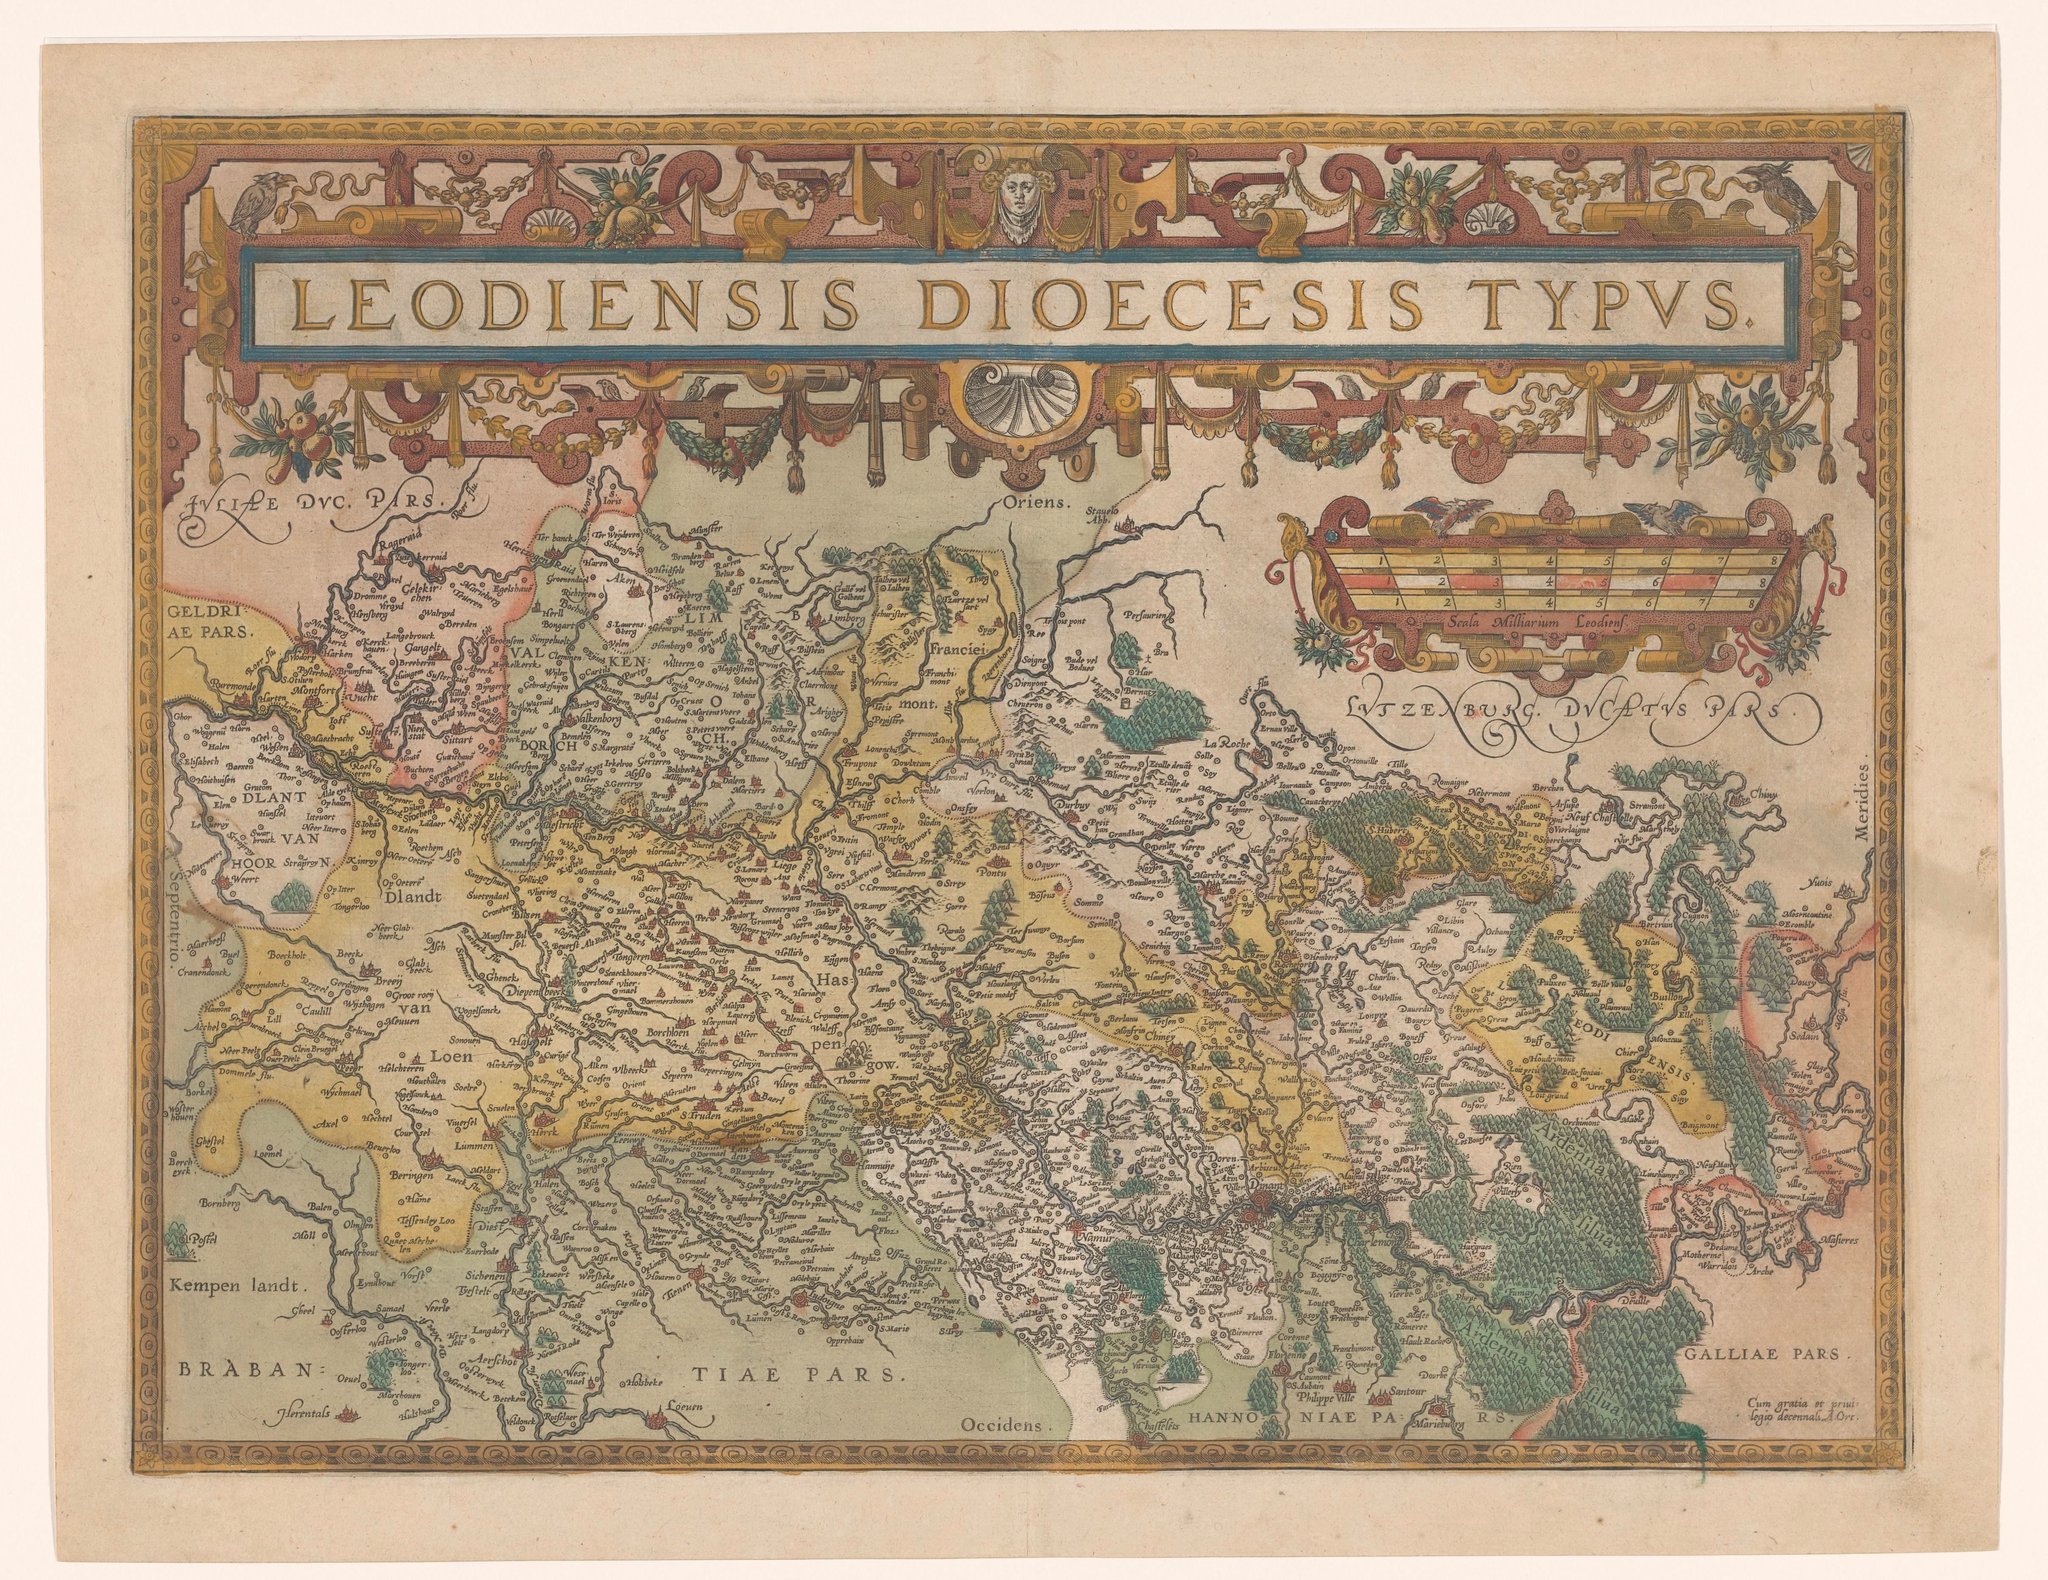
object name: map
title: Leodiensis diocesis typus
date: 1592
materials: paper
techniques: engraving, hand coloring, letterpress printing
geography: antwerp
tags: maps of separate countries or regions, prince-bishopric of liège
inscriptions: collector's mark: Lugt 2228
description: Kaart van het prinsbisdom Luik. Boven de titelcartouche, rijkelijk versierd. Daar rechts onder een cartouche met drie schaalstokken: 8 Scala Milliarium Leodiens. Met Latijnse tekst op verso.